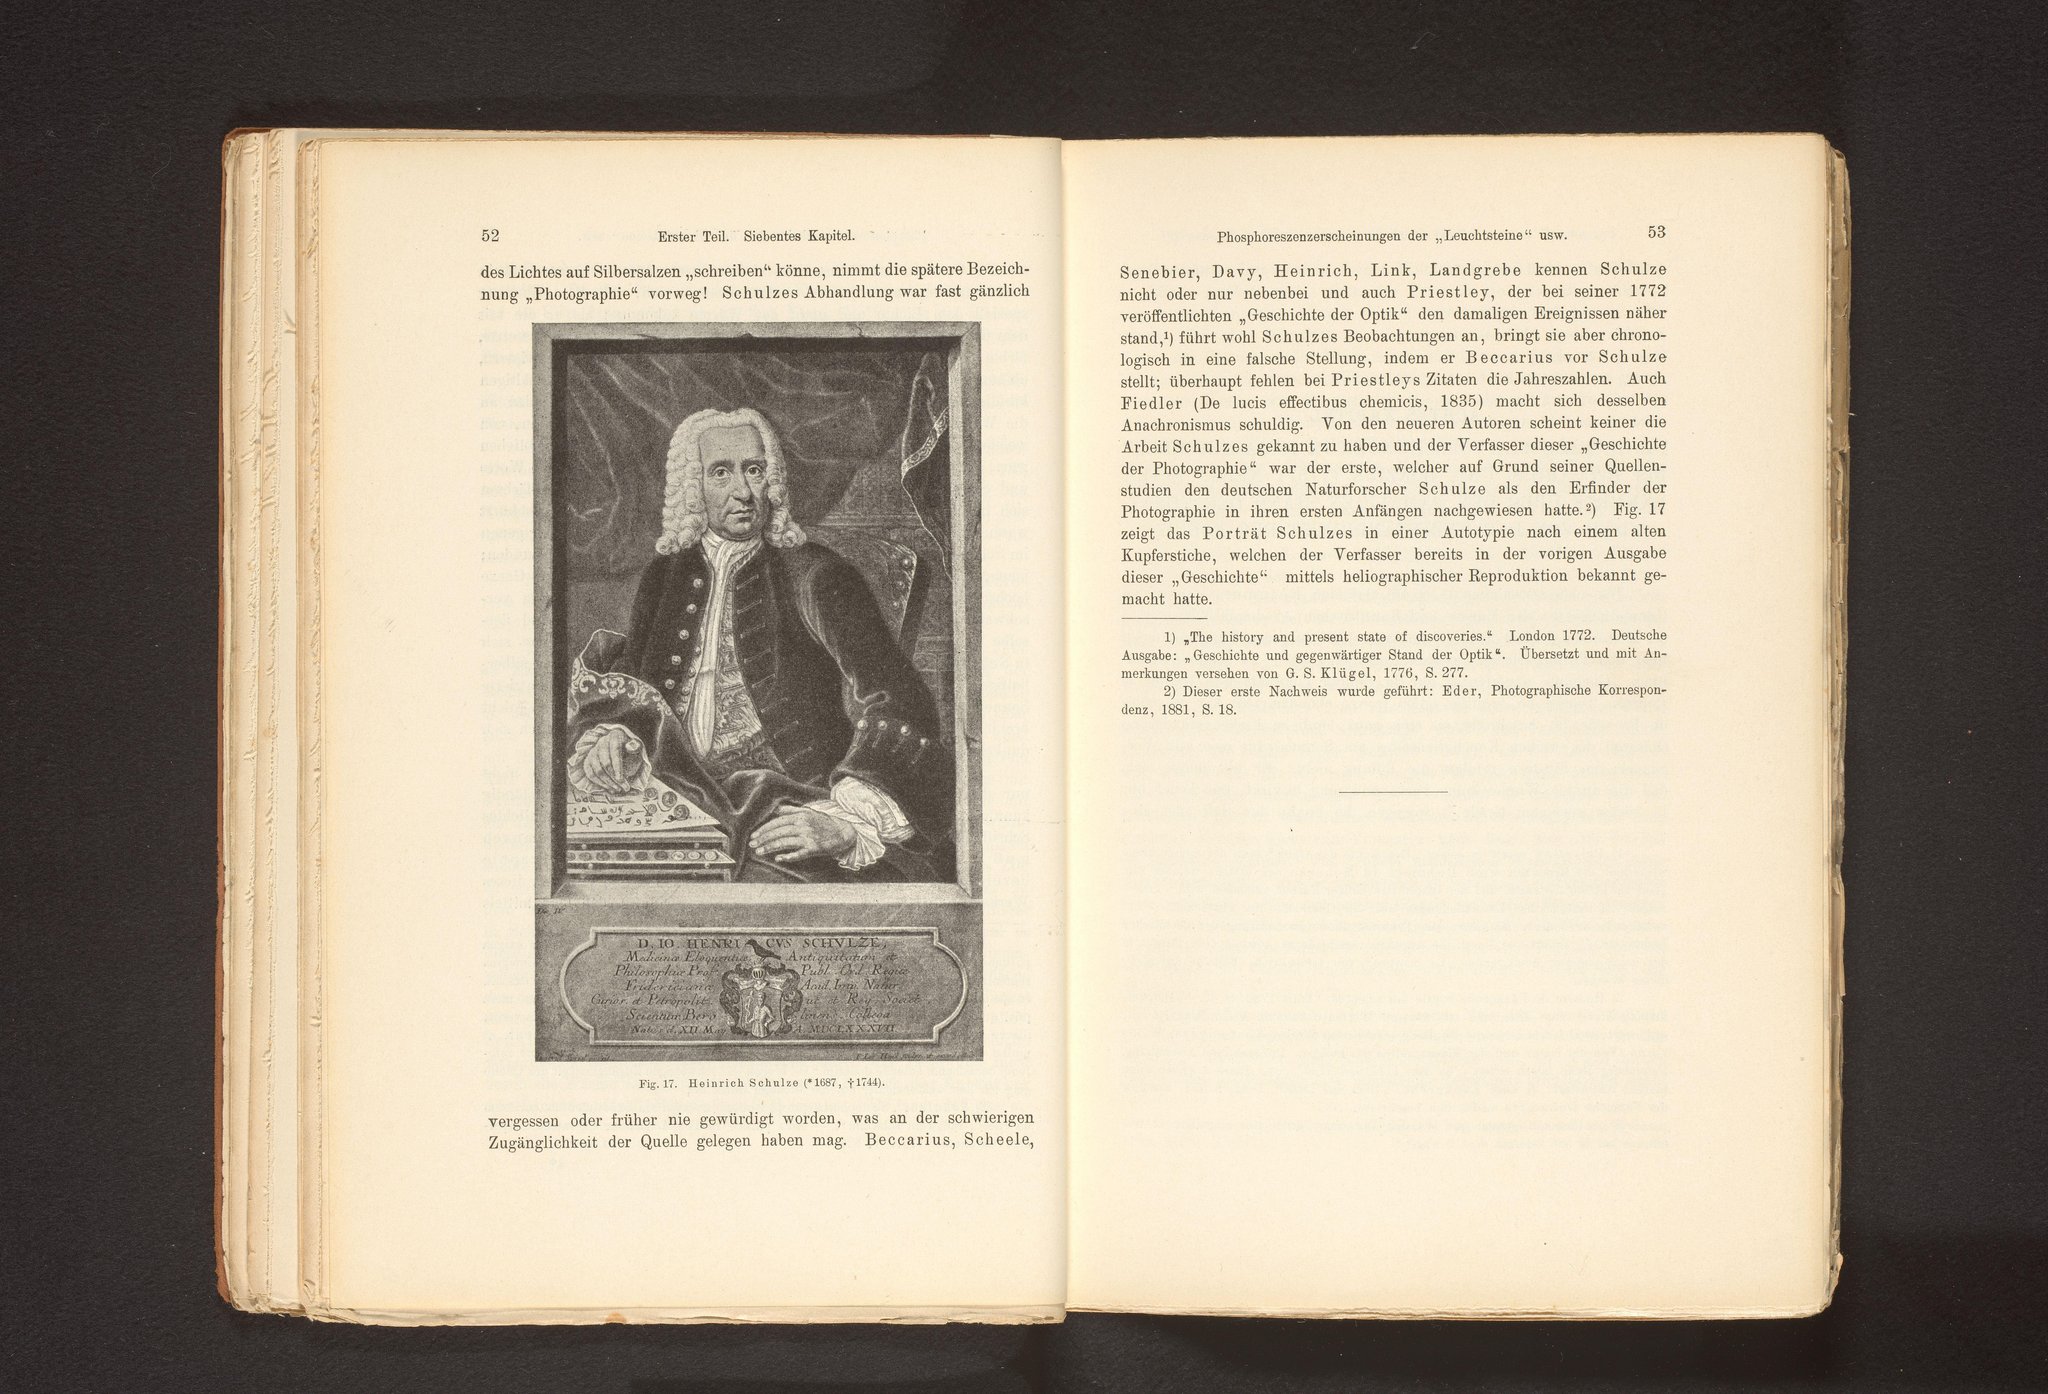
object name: page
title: Fotoreproductie van een schilderij, voorstellende een portret van Johann Heinrich Schulze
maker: Anonymous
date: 1900-1905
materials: paper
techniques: autotype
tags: halle, magic lantern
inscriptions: number: ‘Fig. 17.’